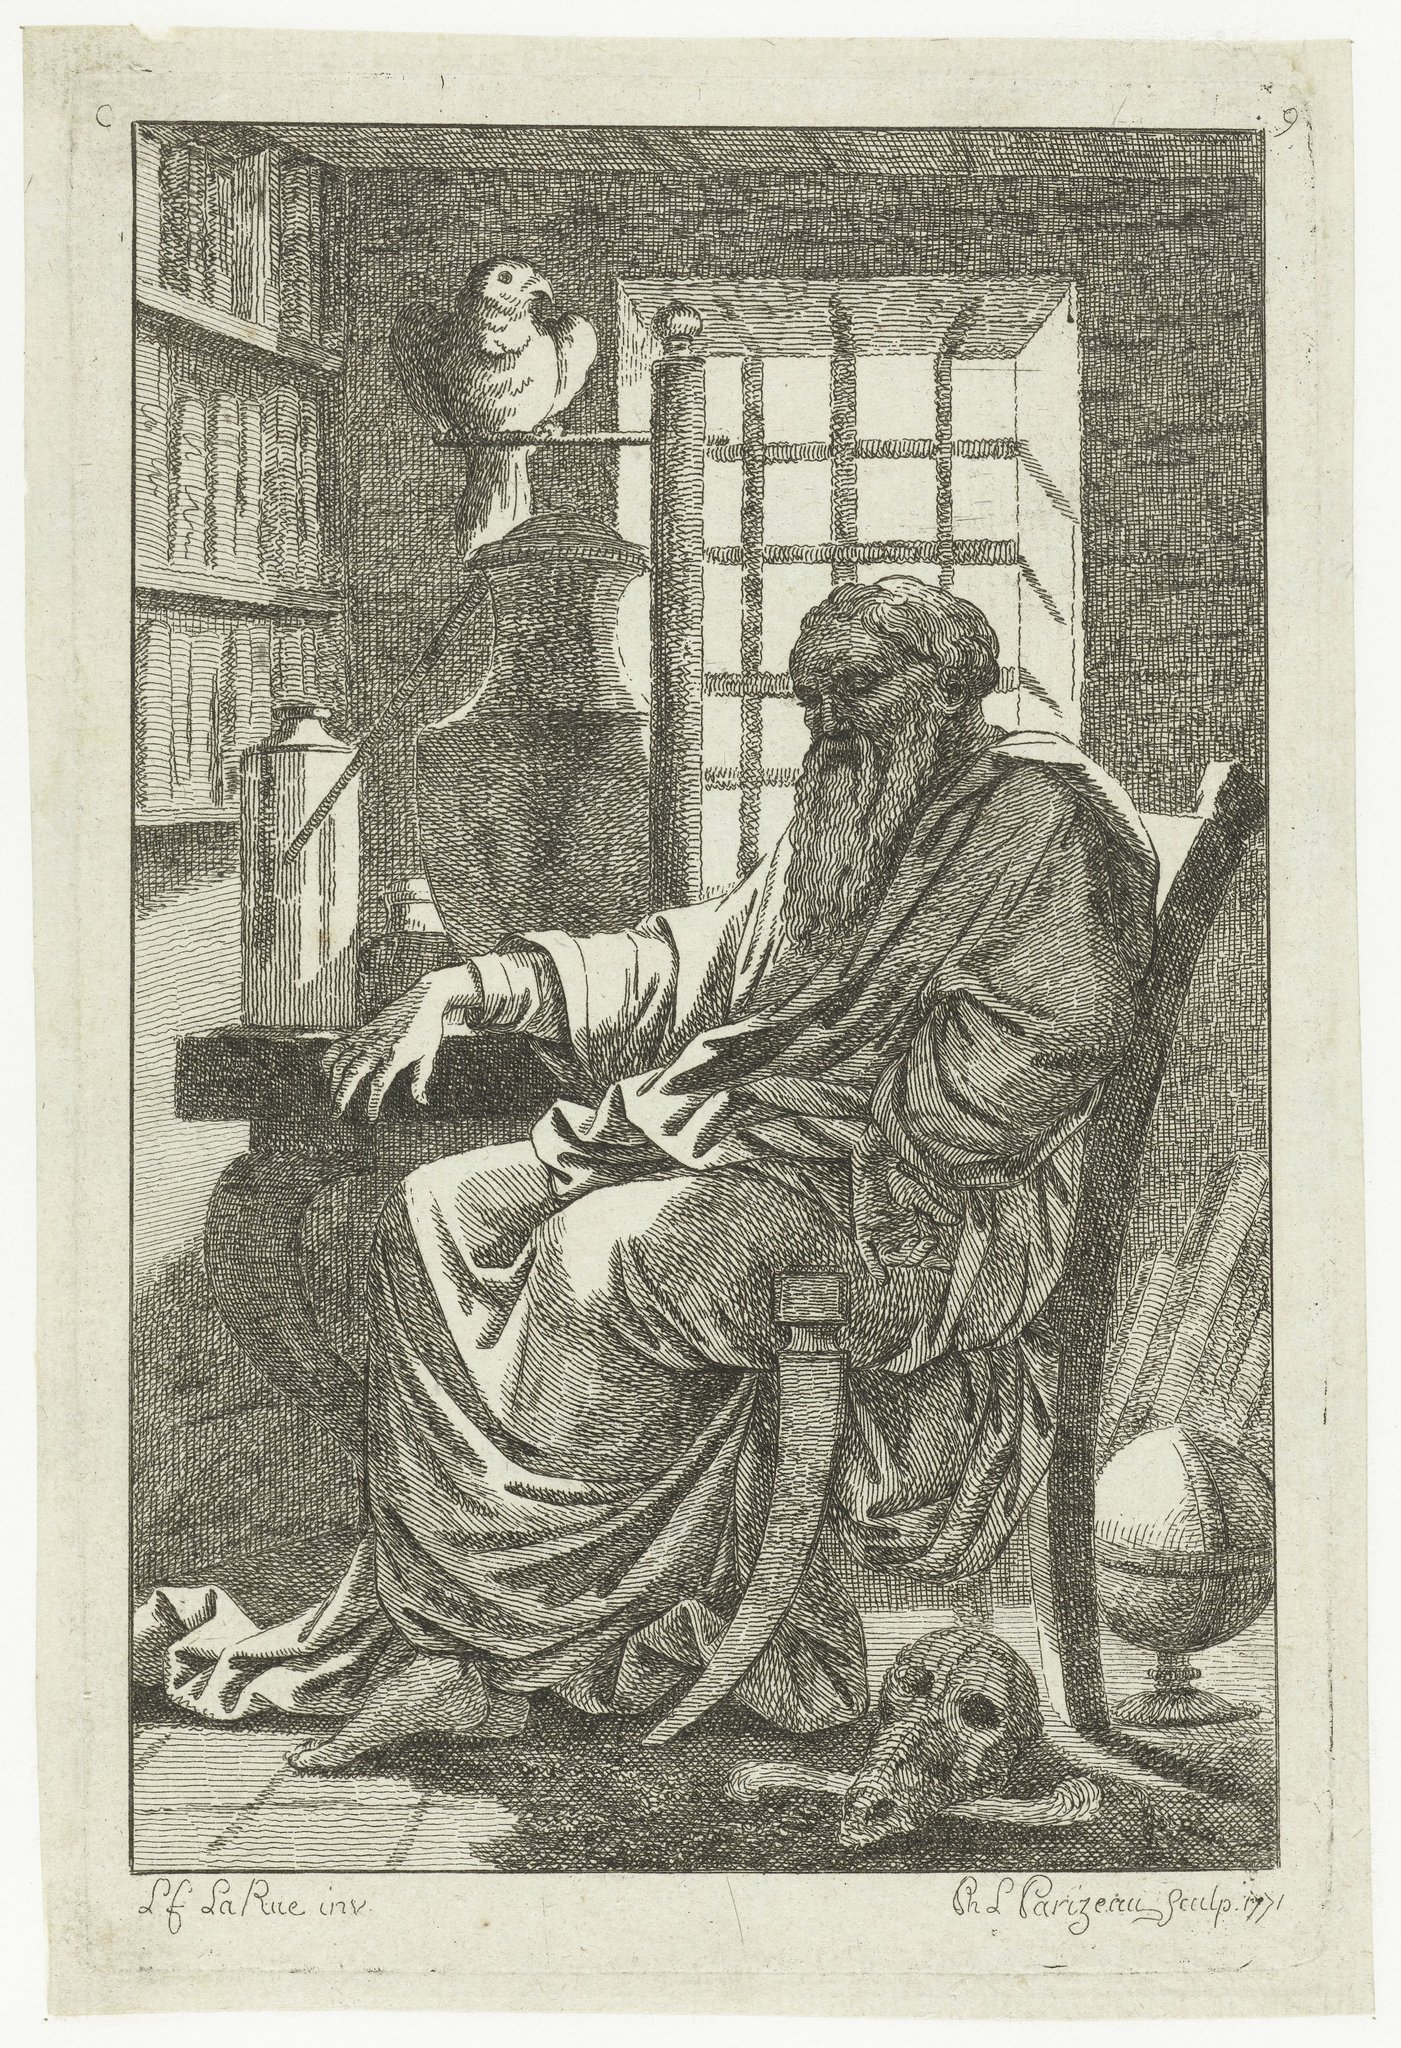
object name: print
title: Historische en mythologische scènes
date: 1771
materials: paper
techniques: etching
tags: scholar in his study, ornamental birds: parrot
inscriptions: collector's mark: Lugt 2228, collector's mark: Lugt 2273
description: Een geleerde zittend op een stoel in zijn studeervertrek, naast hem een papegaai op een stok.